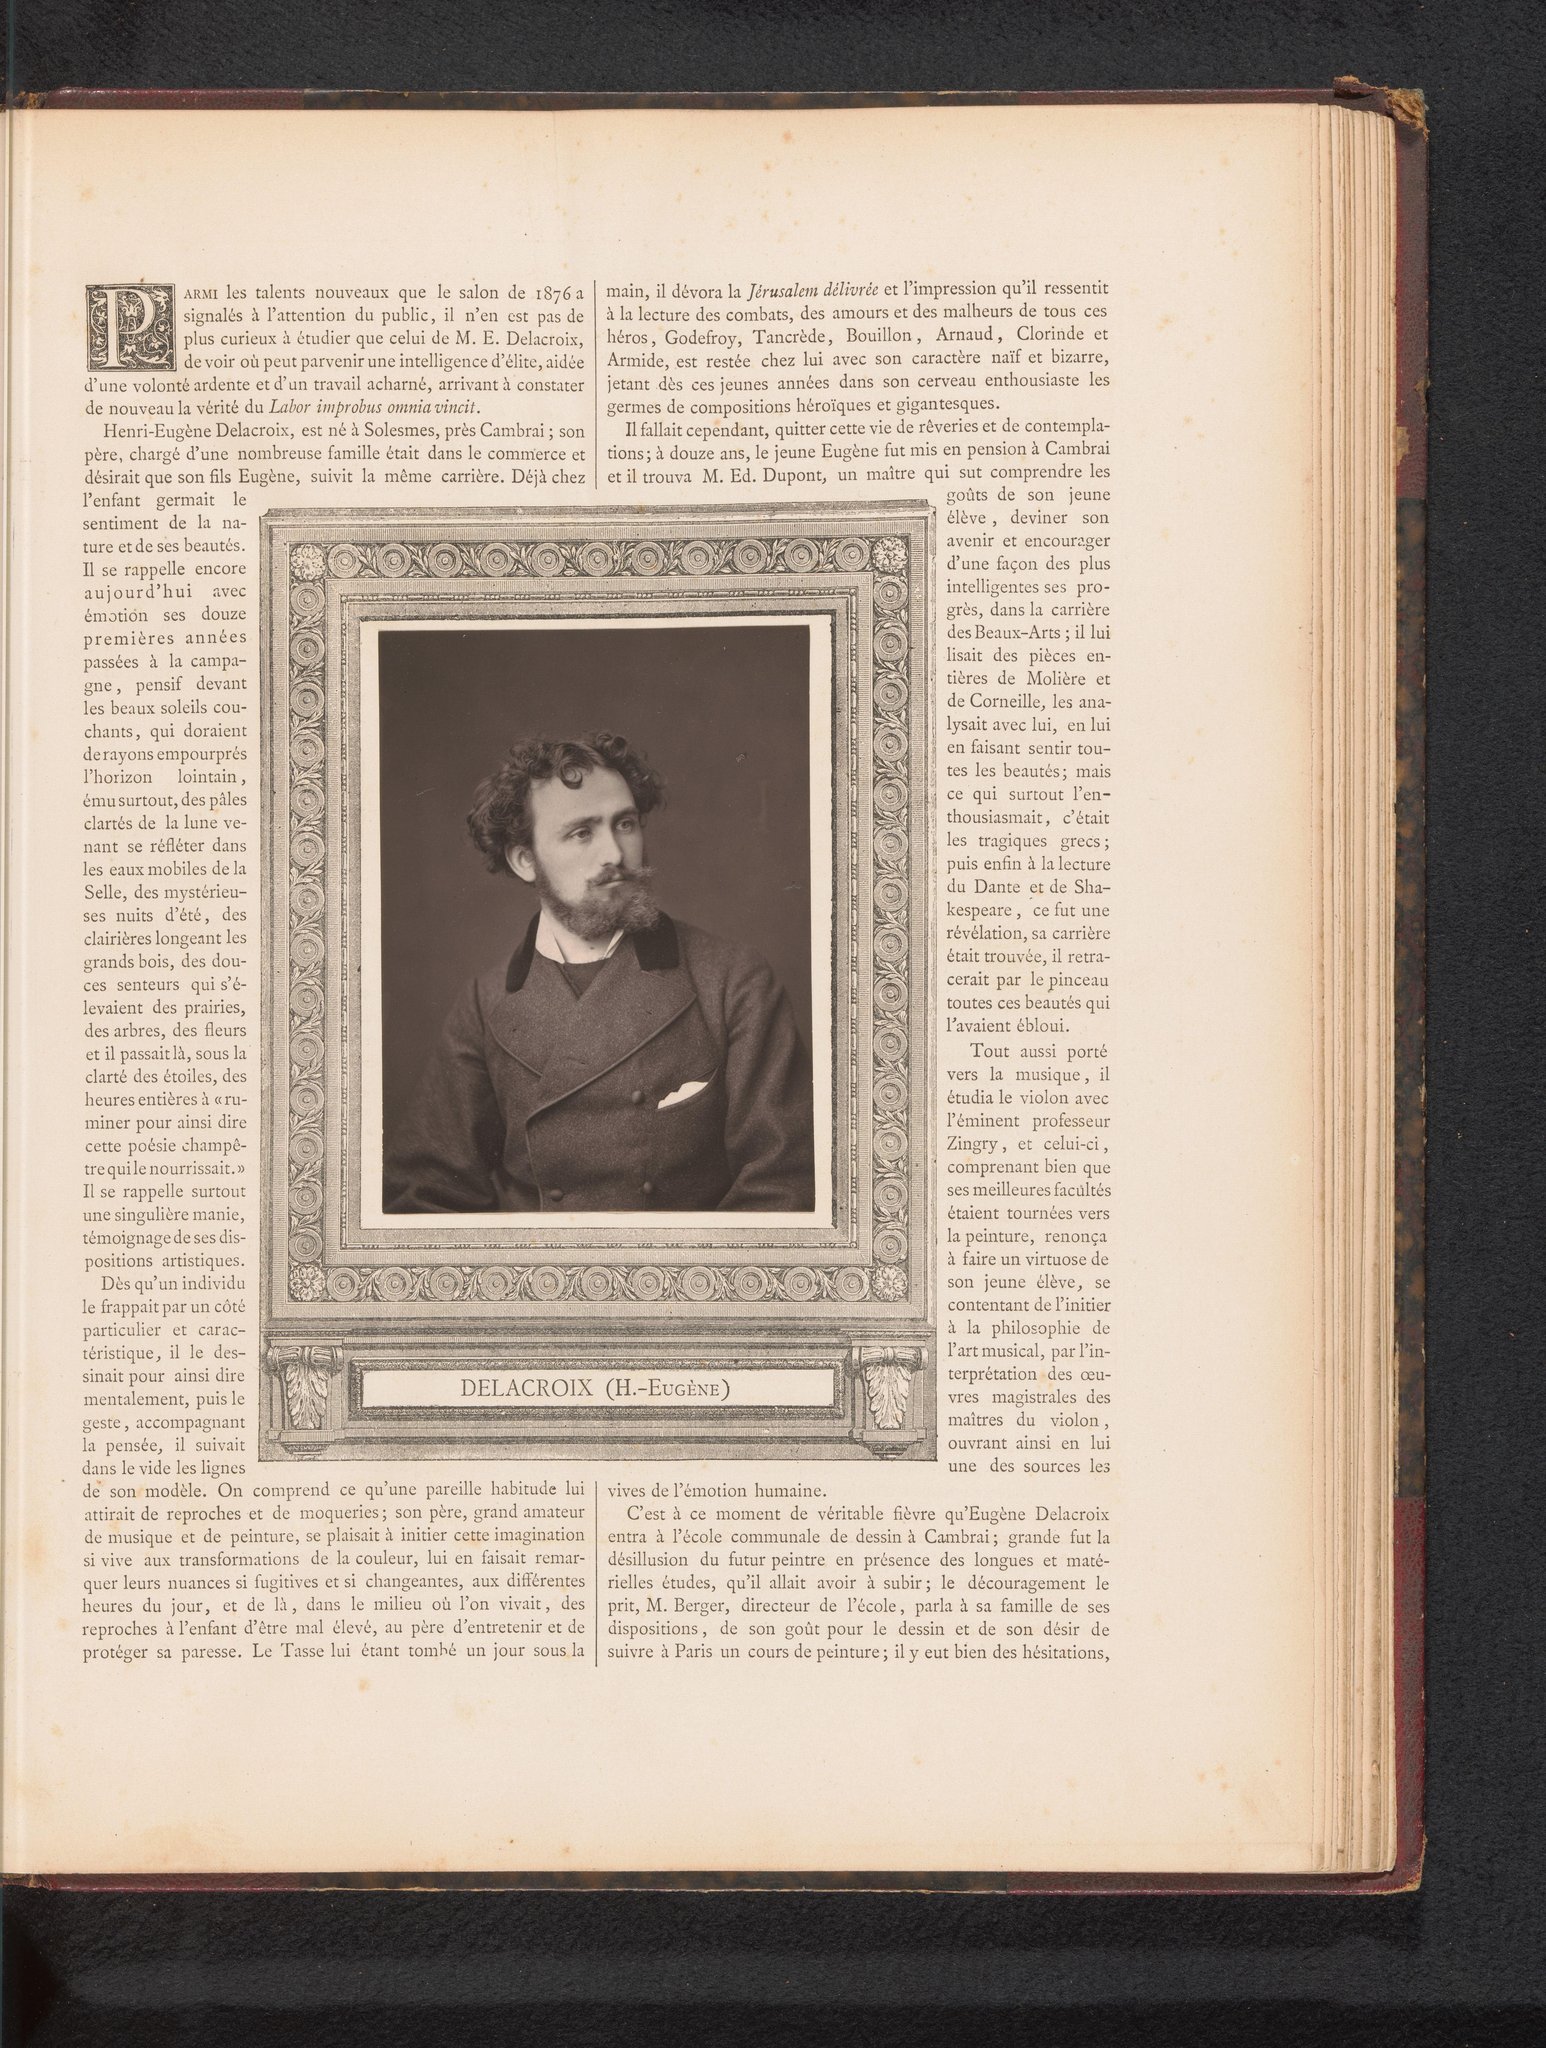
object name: page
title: Delacroix (H.-Eugène)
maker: Anonymous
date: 1871-1876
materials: paper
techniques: woodburytype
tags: painter, henri eugène delacroix, adult man, historical persons